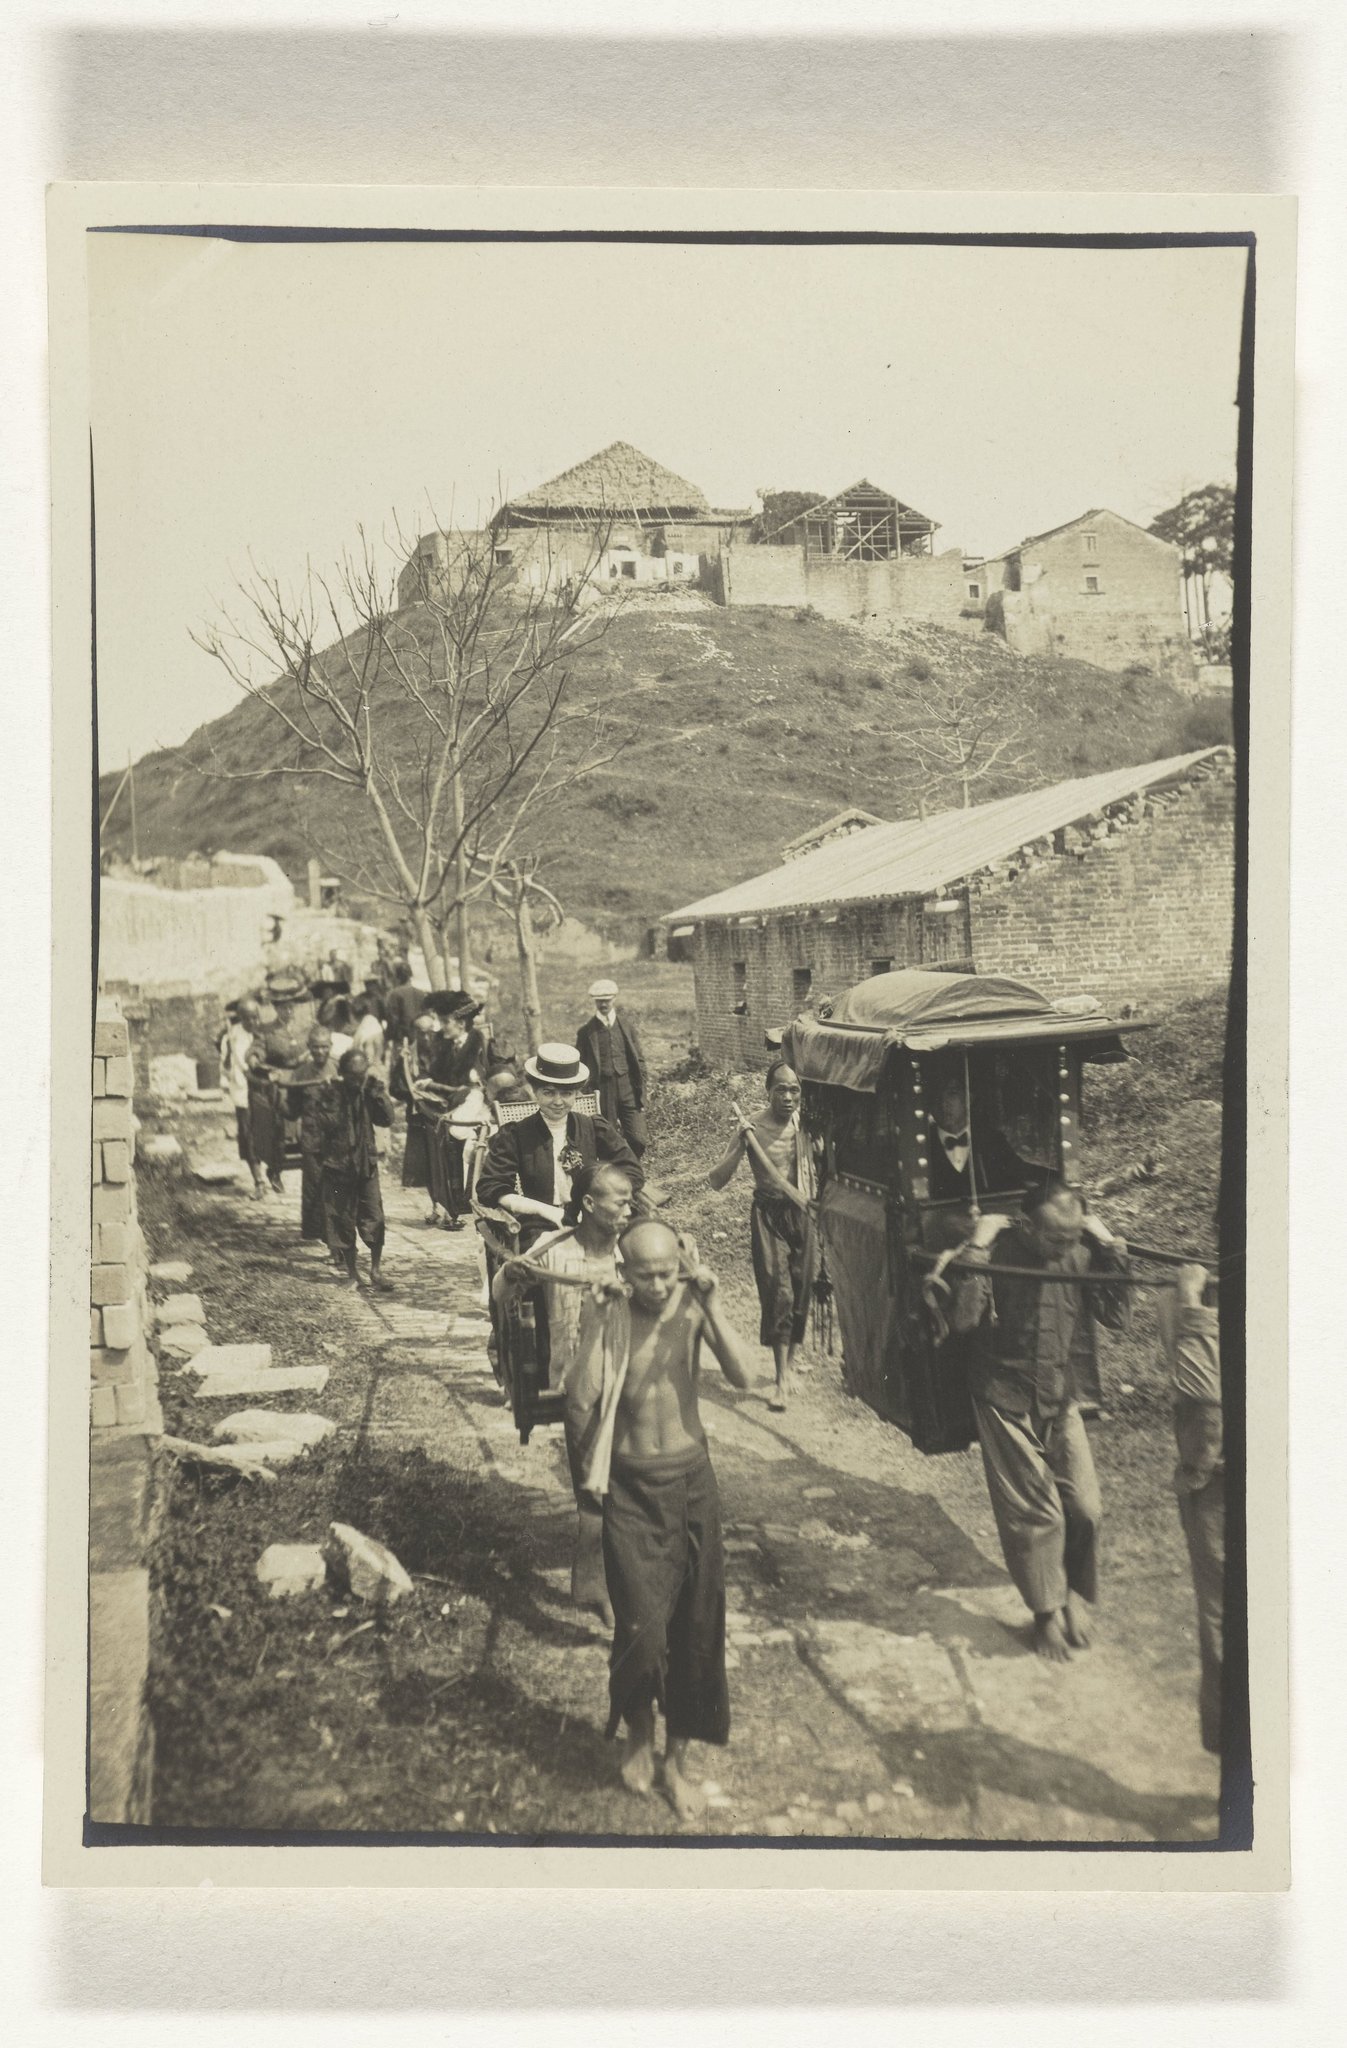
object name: photograph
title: Canton Chair Conveyance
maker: geldolph adriaan kessler (dolph)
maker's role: fotograaf, industrieel, voetballer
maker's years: 1884-1945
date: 1908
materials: cardboard, photographic support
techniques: gelatin silver print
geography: hong kong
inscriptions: title: ‘Canton Chan Conveyance’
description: Het Europese gezelschap wordt per draagstoel vervoerd door Chinese dragers waarbij gebruik wordt gemaakt van zowel open als gesloten draagstoelen vermoedelijk in de heuvels van Hong Kong. Onderdeel van het fotoalbum van Dolph Kessler met opnamen die hij maakte tijdens zijn verblijf in Engeland en op een wereldreis die hij als secretaris van Henri Deterding (directeur Koninklijke Olie) ondernam naar Nederlands-Indië, Japan, China en de Verenigde Staten, tussen 1906 en 1908.